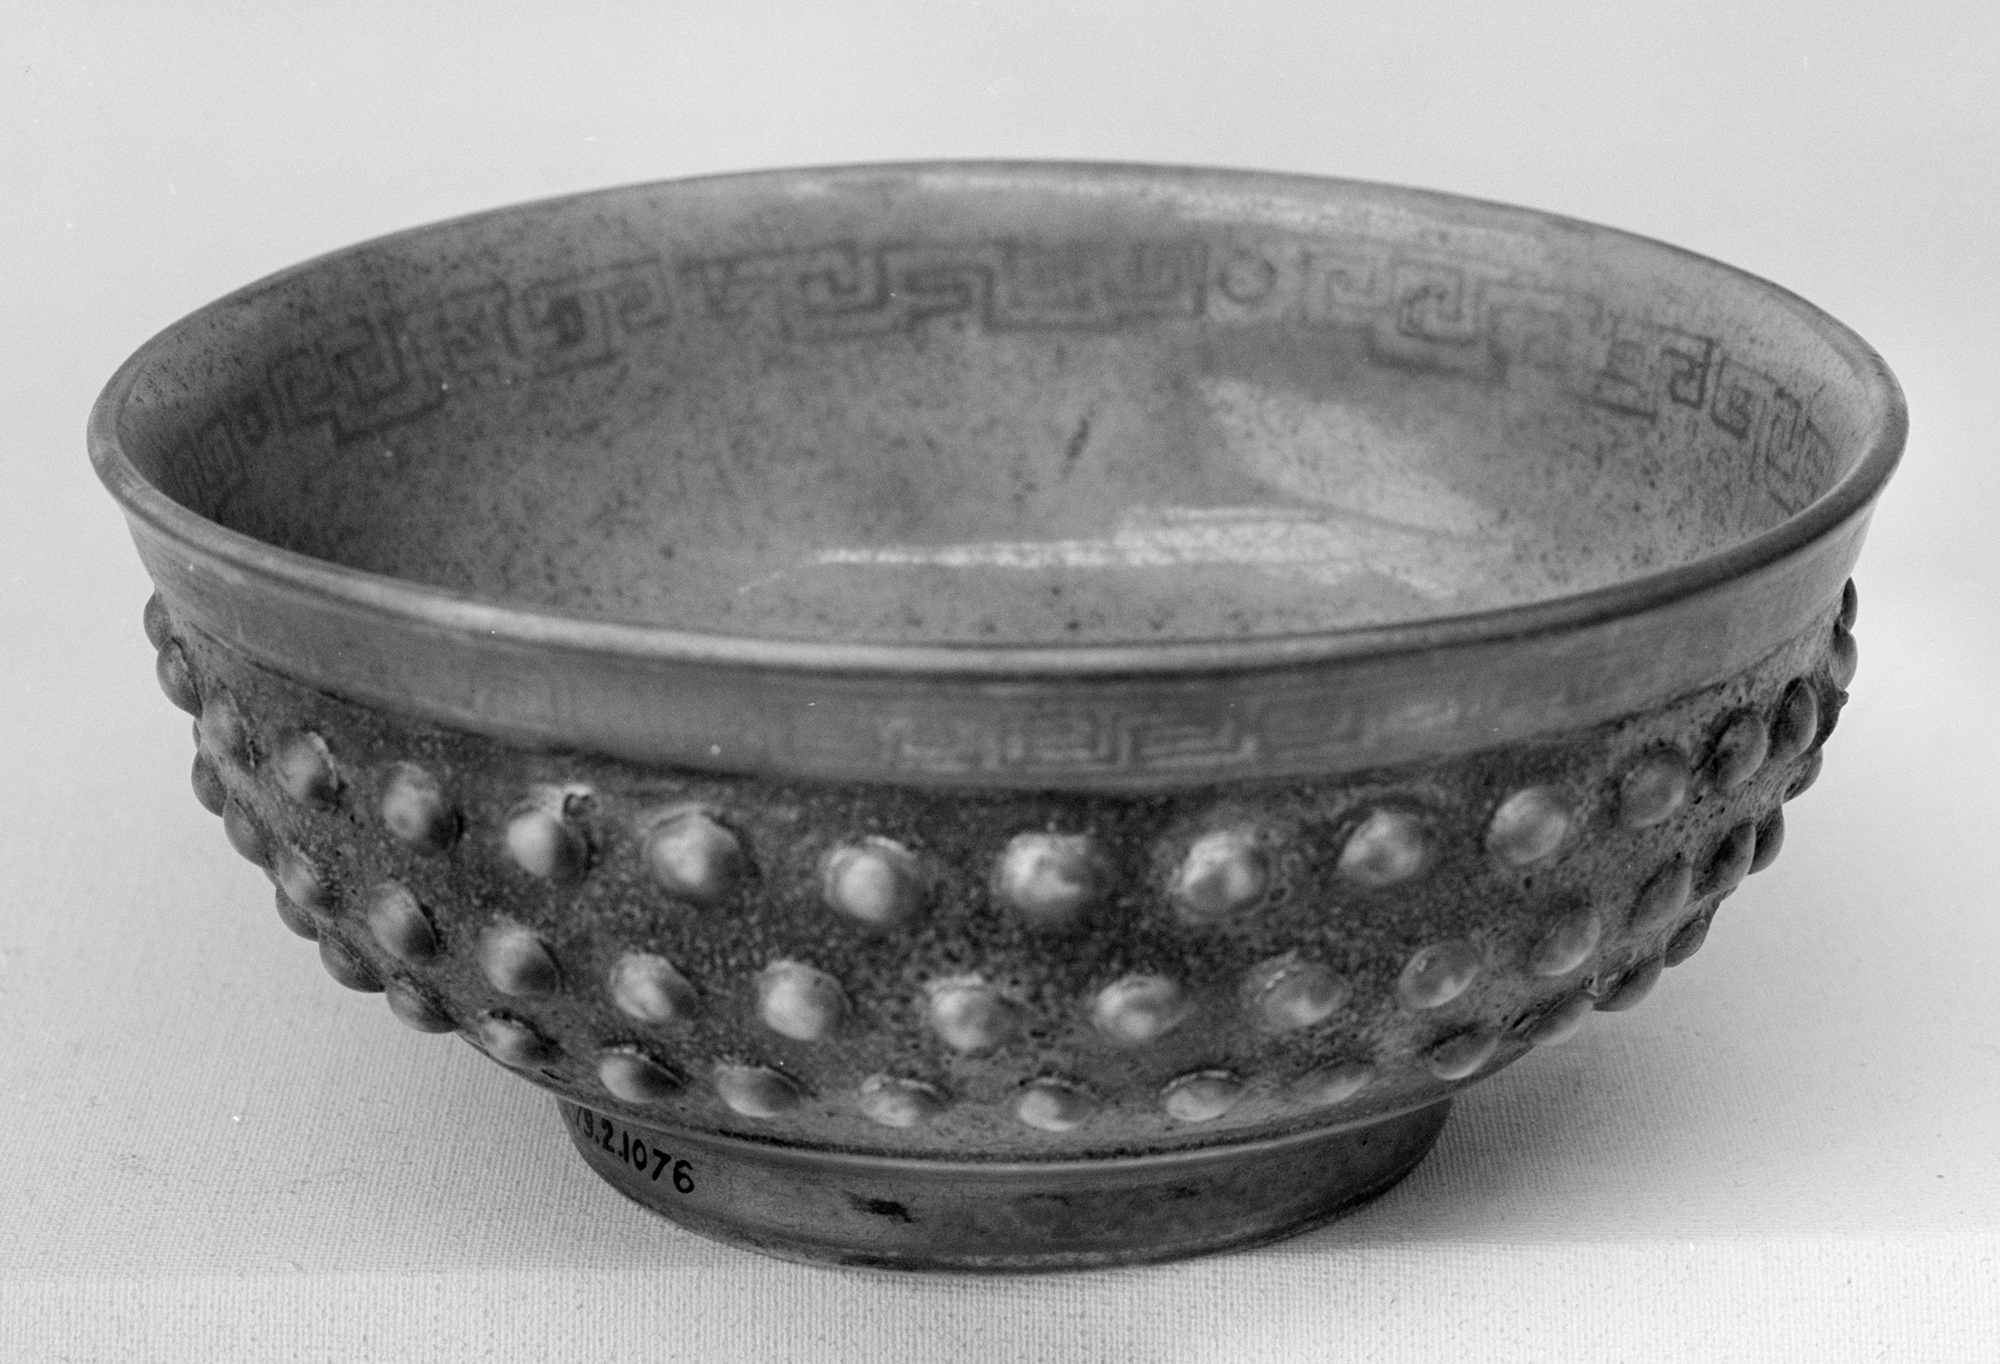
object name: bowl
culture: chinese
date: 1801-1900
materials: bronze, gilt, glaze, porcelain